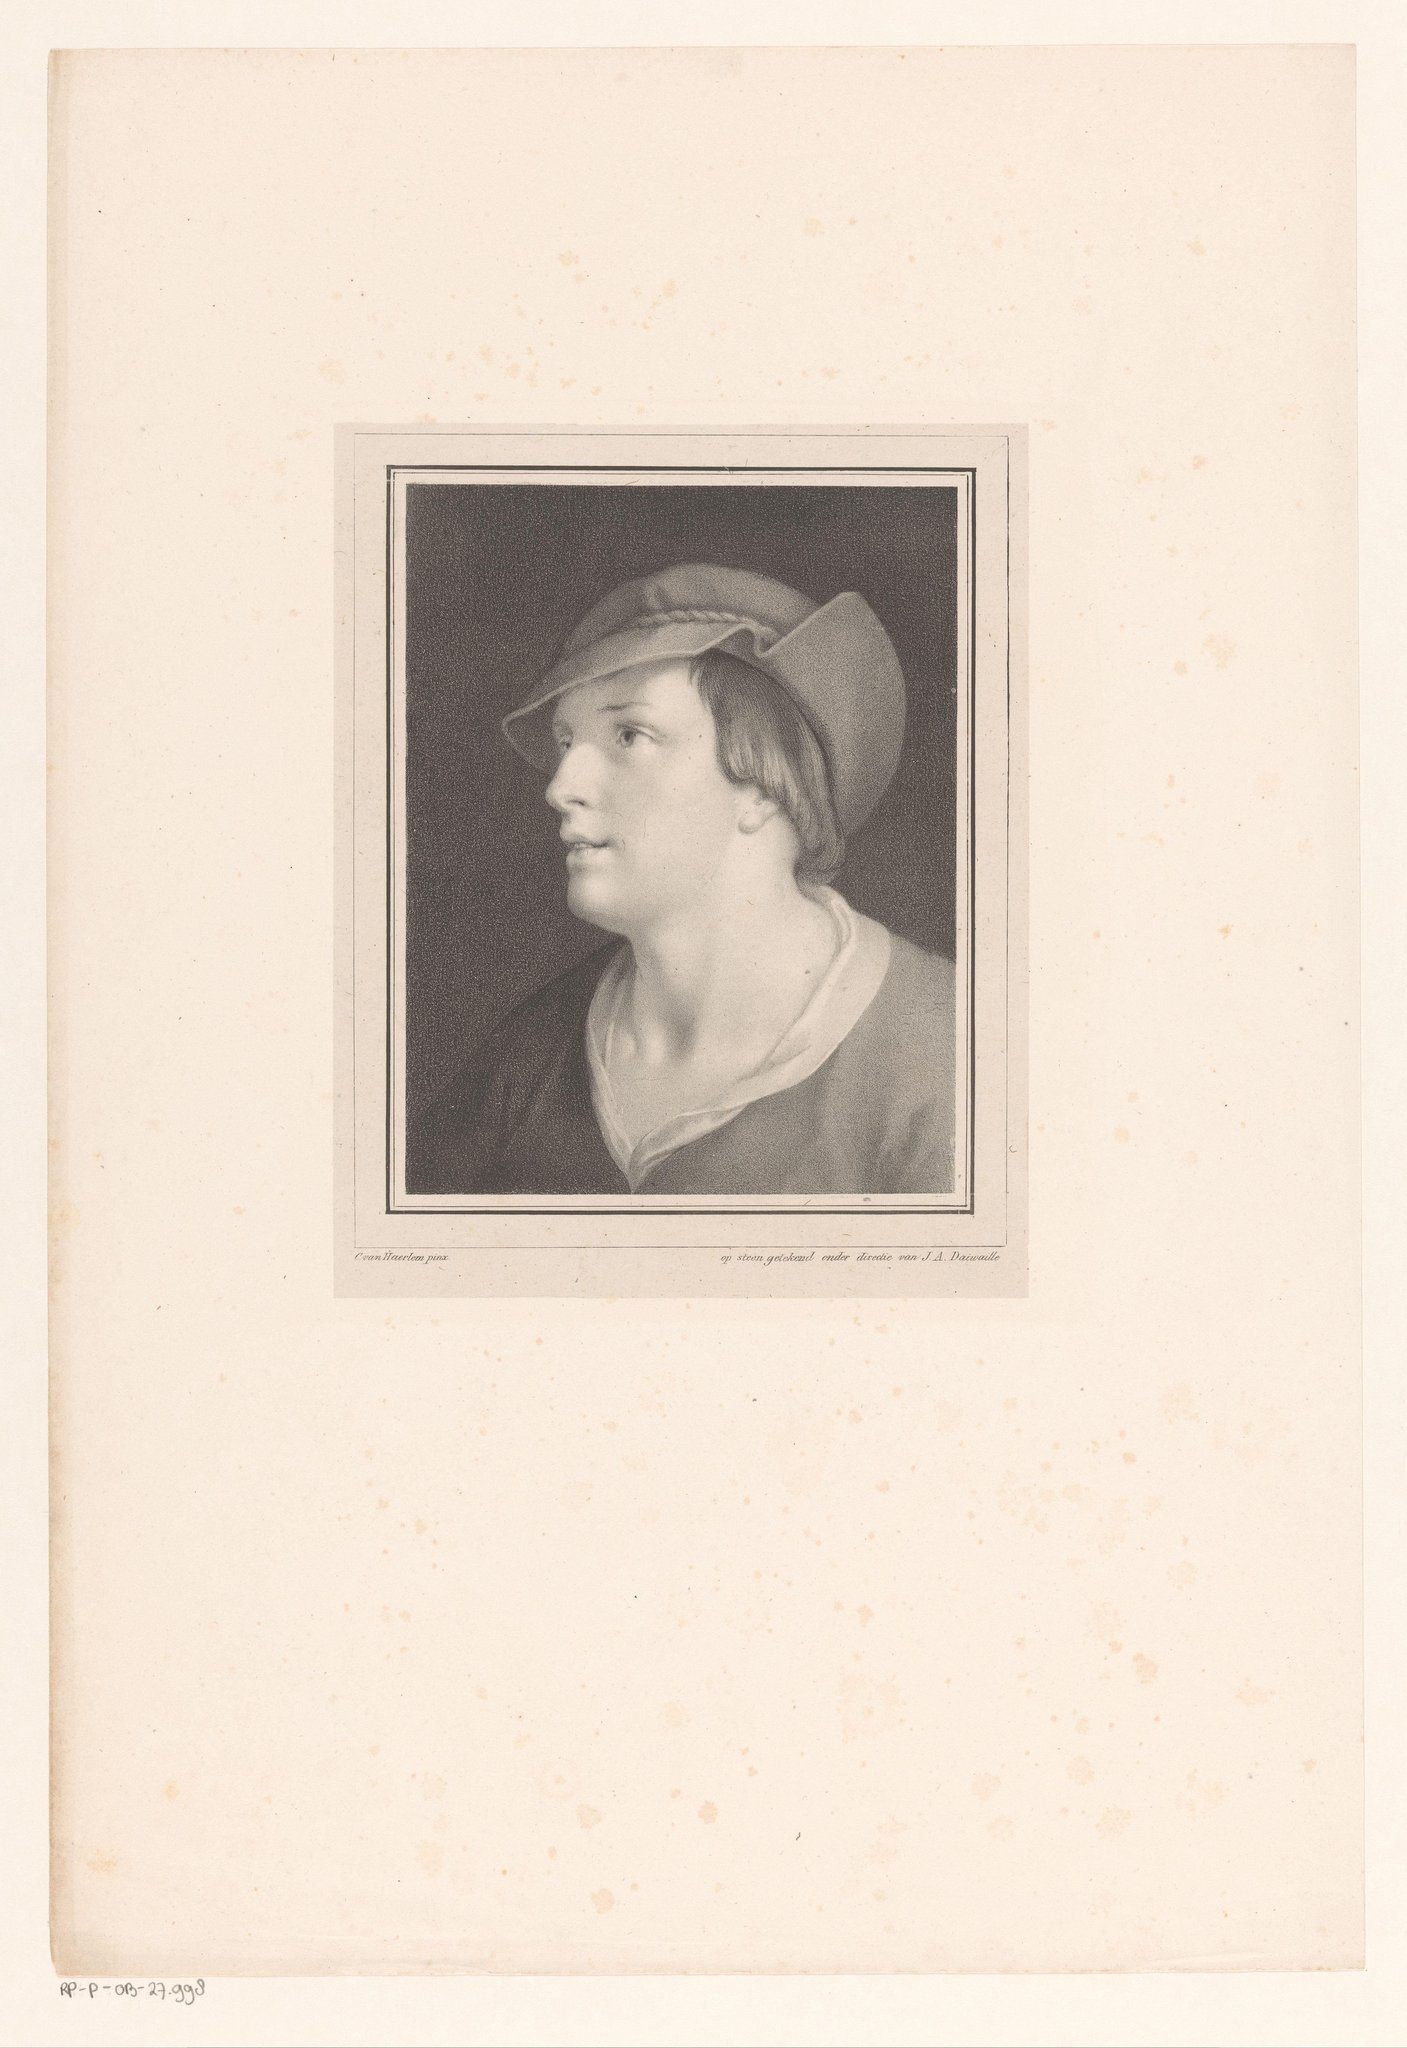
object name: print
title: Portret van een jongeman met baret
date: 1809-1850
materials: paper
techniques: lithograph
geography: amsterdam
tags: historical persons (+ head (and shoulders) (portrait)), youth, adolescent (+ three-quarter view), head-gear: beret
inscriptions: collector's mark: Lugt 2228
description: De jongen kijkt naar linksboven. De rand van zijn baret staat gedeeltelijk omhoog.